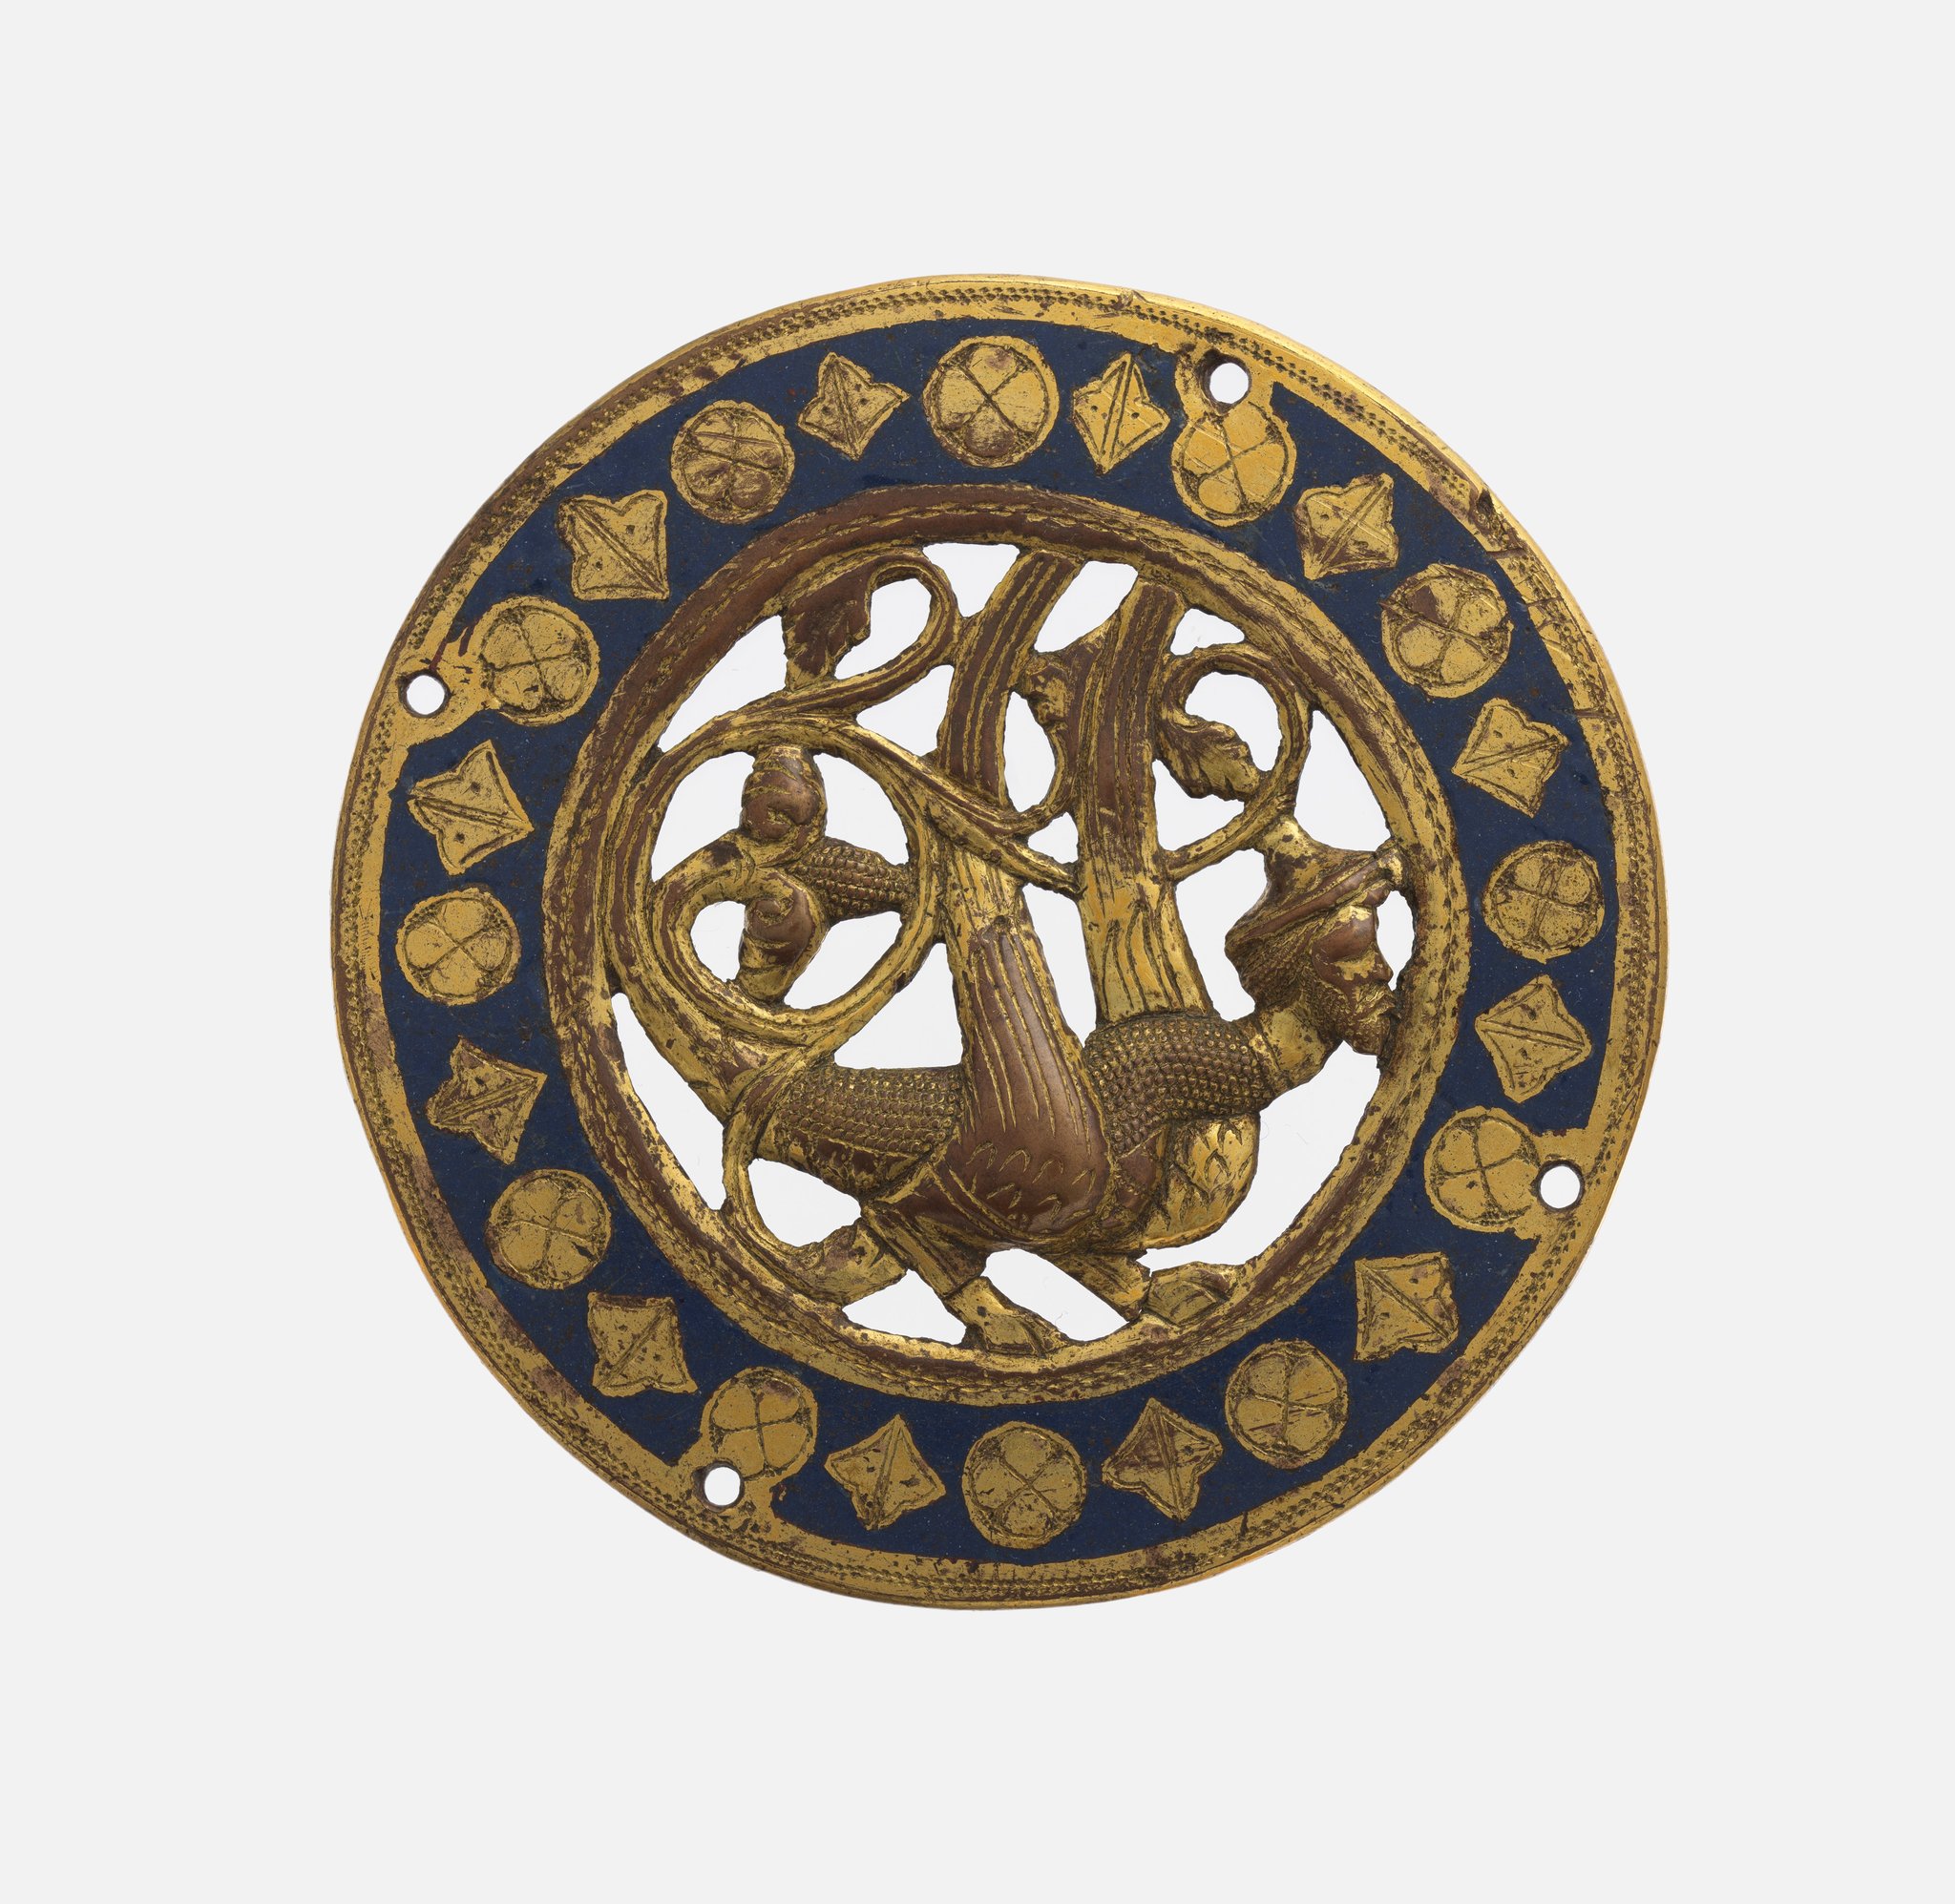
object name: medallion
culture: french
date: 1227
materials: copper, enamel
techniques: enamel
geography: france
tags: mythical creatures